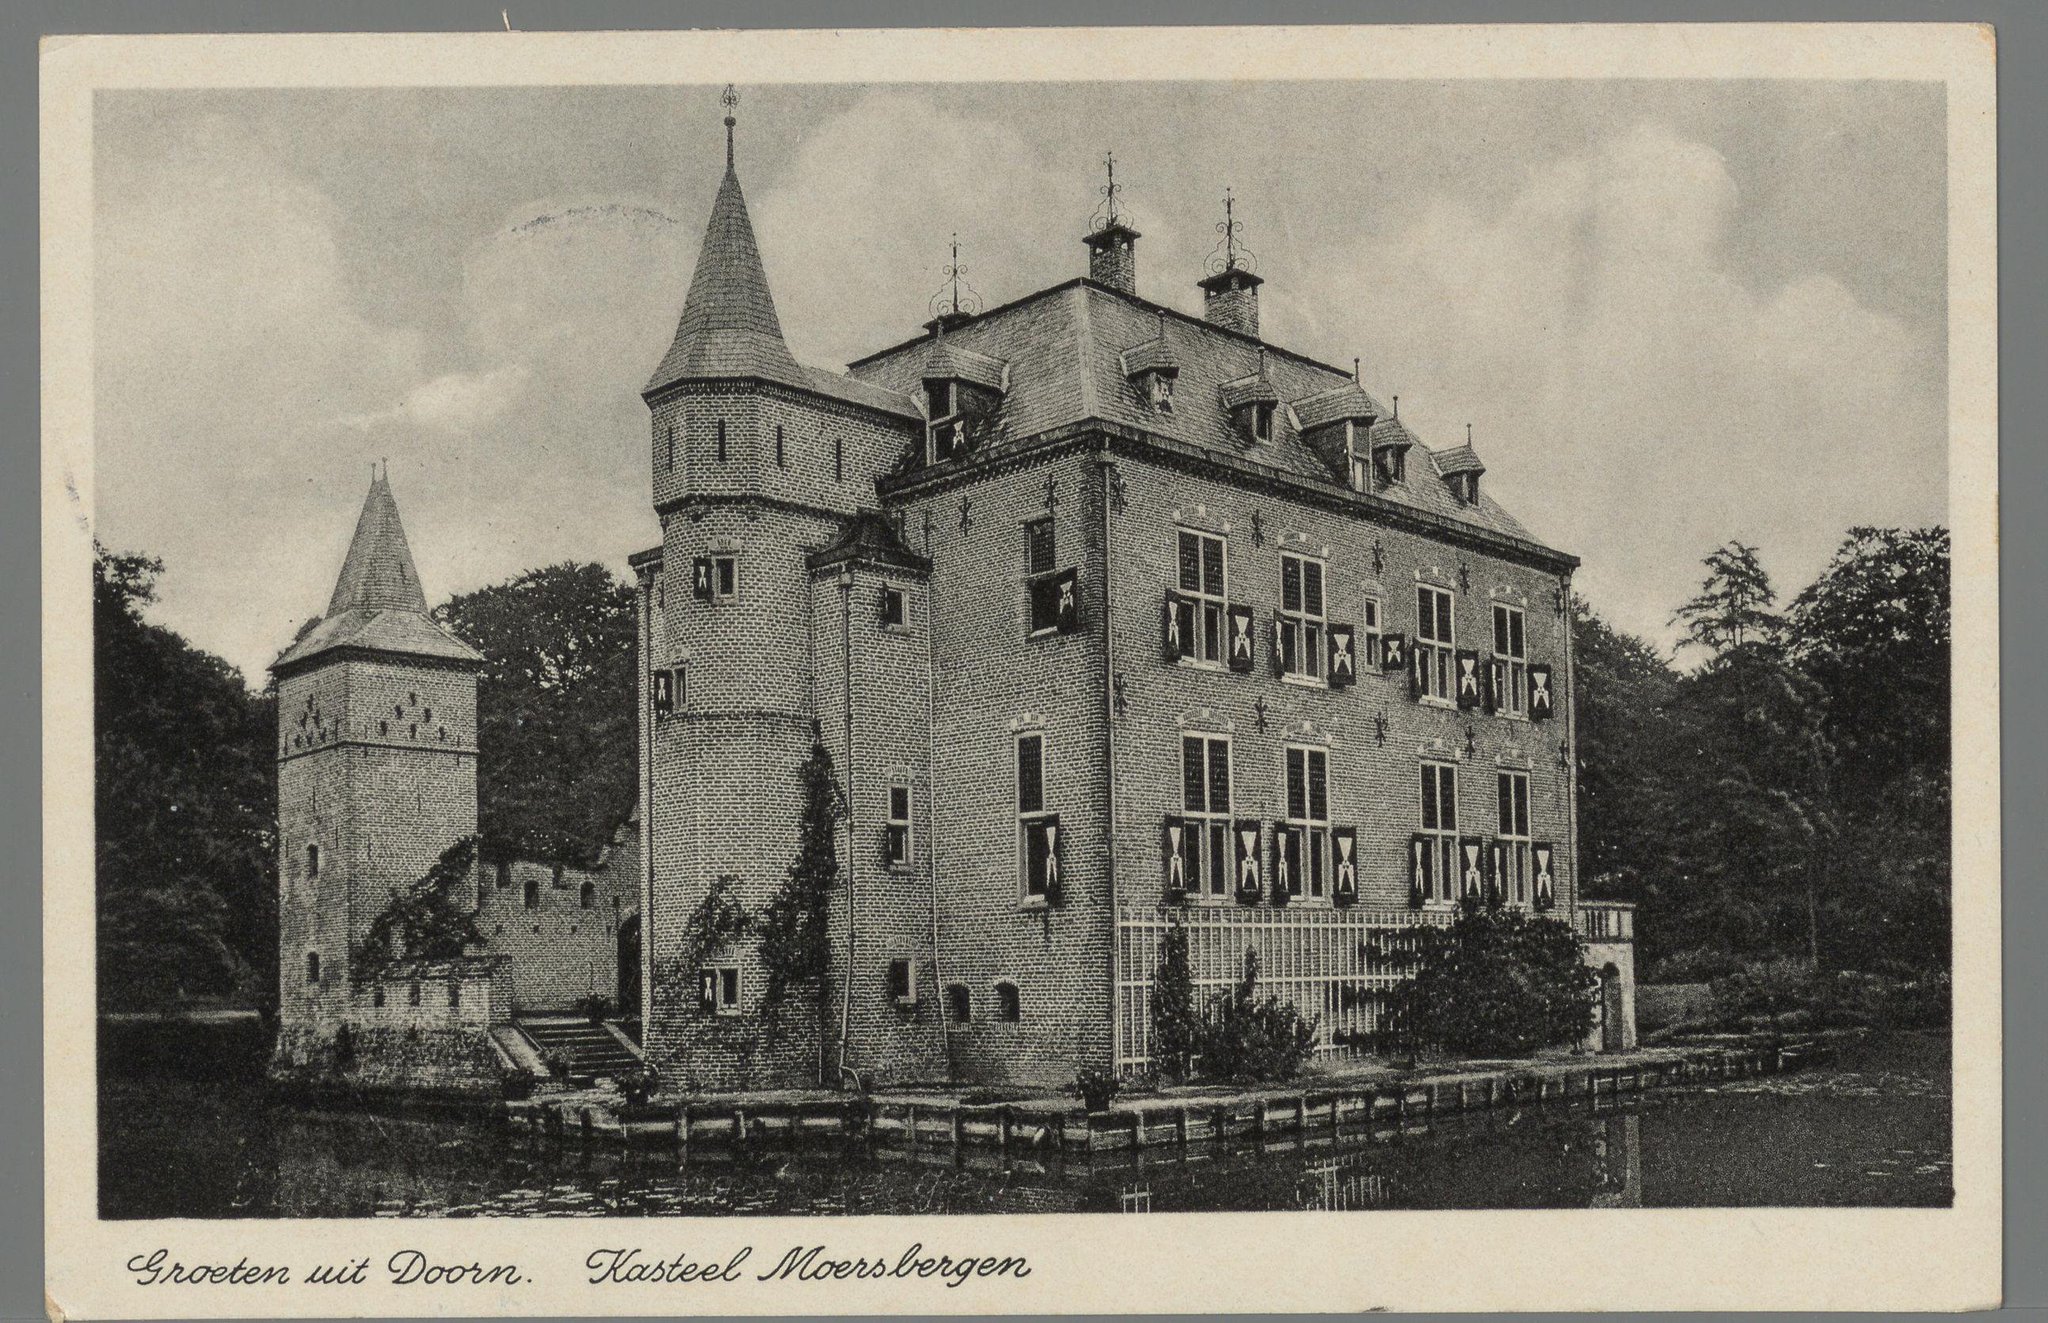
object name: ansichtkaart, prentbriefkaart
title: Groeten uit Doorn. Kasteel Moersbergen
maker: Anonymous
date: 1913-1941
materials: cardboard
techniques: photograph, writing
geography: doorn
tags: castle, canal, kasteel moersbergen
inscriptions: postage stamp